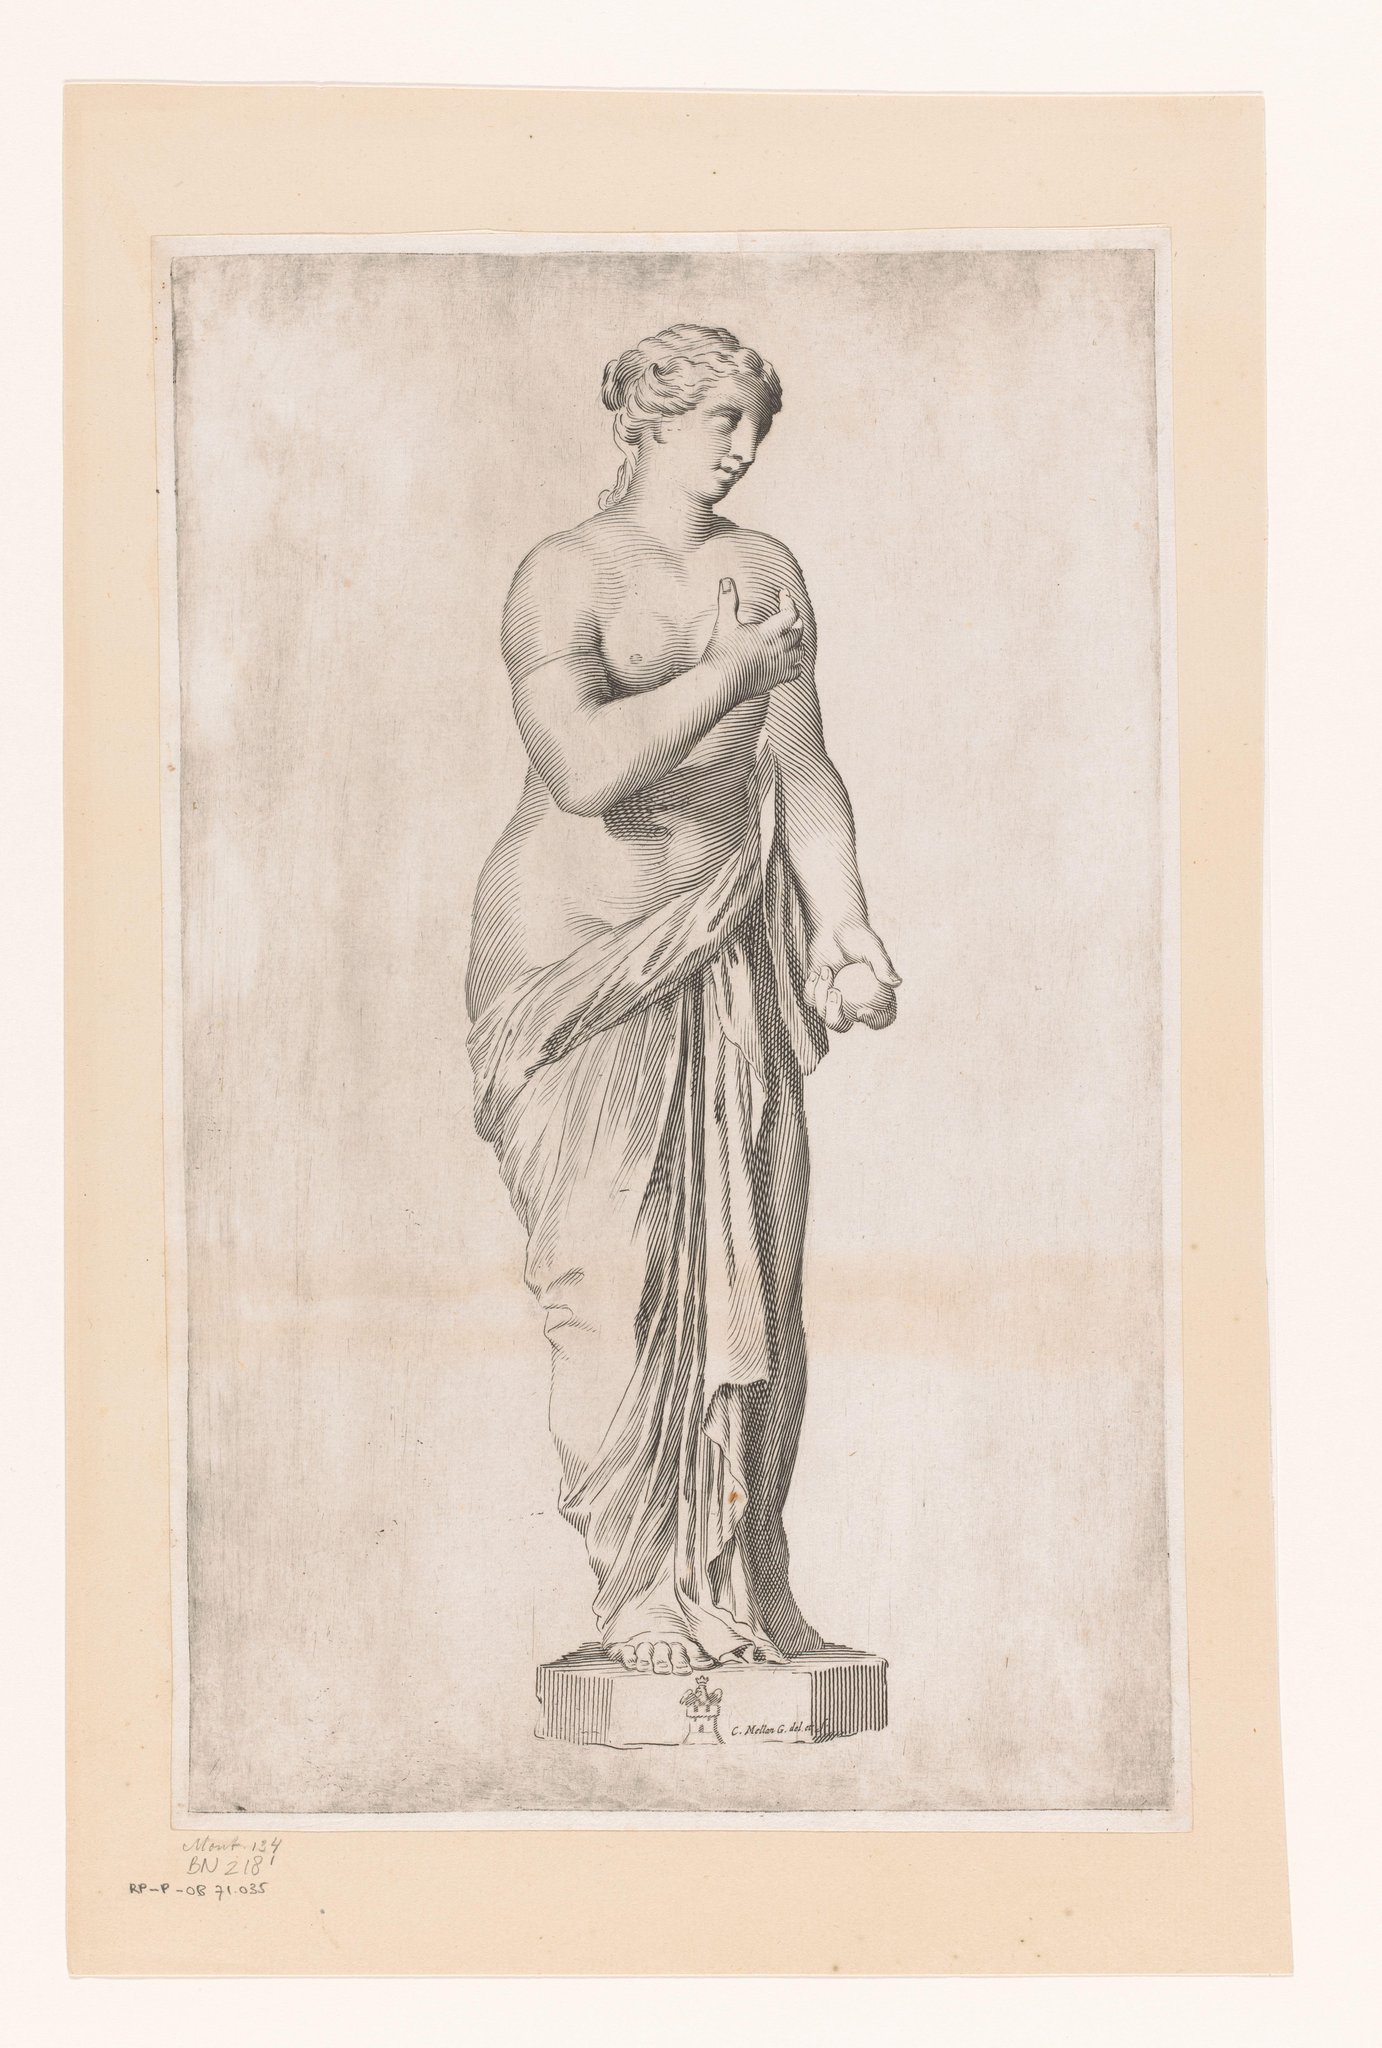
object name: print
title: Galleria Giustiniana del Marchese Vincenzo Giustiniani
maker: claude mellan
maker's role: draughtsman, print maker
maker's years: 1598-1688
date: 1631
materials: paper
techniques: engraving, intaglio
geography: rome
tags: rome, vincenzo giustiniani (1564-1637), piece of sculpture, reproduction of a piece of sculpture, (story of) venus (aphrodite)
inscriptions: collector's mark: Lugt 240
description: Maakt deel uit van een serie bestaande uit 322 prenten van kunstwerken uit de collectie van Vincenzo Giustiniani die in twee volumes werd uitgegeven door Joachim von Sandrart in 1636 en 1637 (zie British Museum, inv.nr. 1851,1213.565). De serie bestaat uit prenten door verschillende kunstenaars zoals Cornelis Bloemaert, Theodore Matham, Pieter de Bailliu en Michel Natalis. Claude Mellan was verantwoordelijk voor 22 prenten van standbeelden en het 1631 gedateerde portret van Giustiniani.